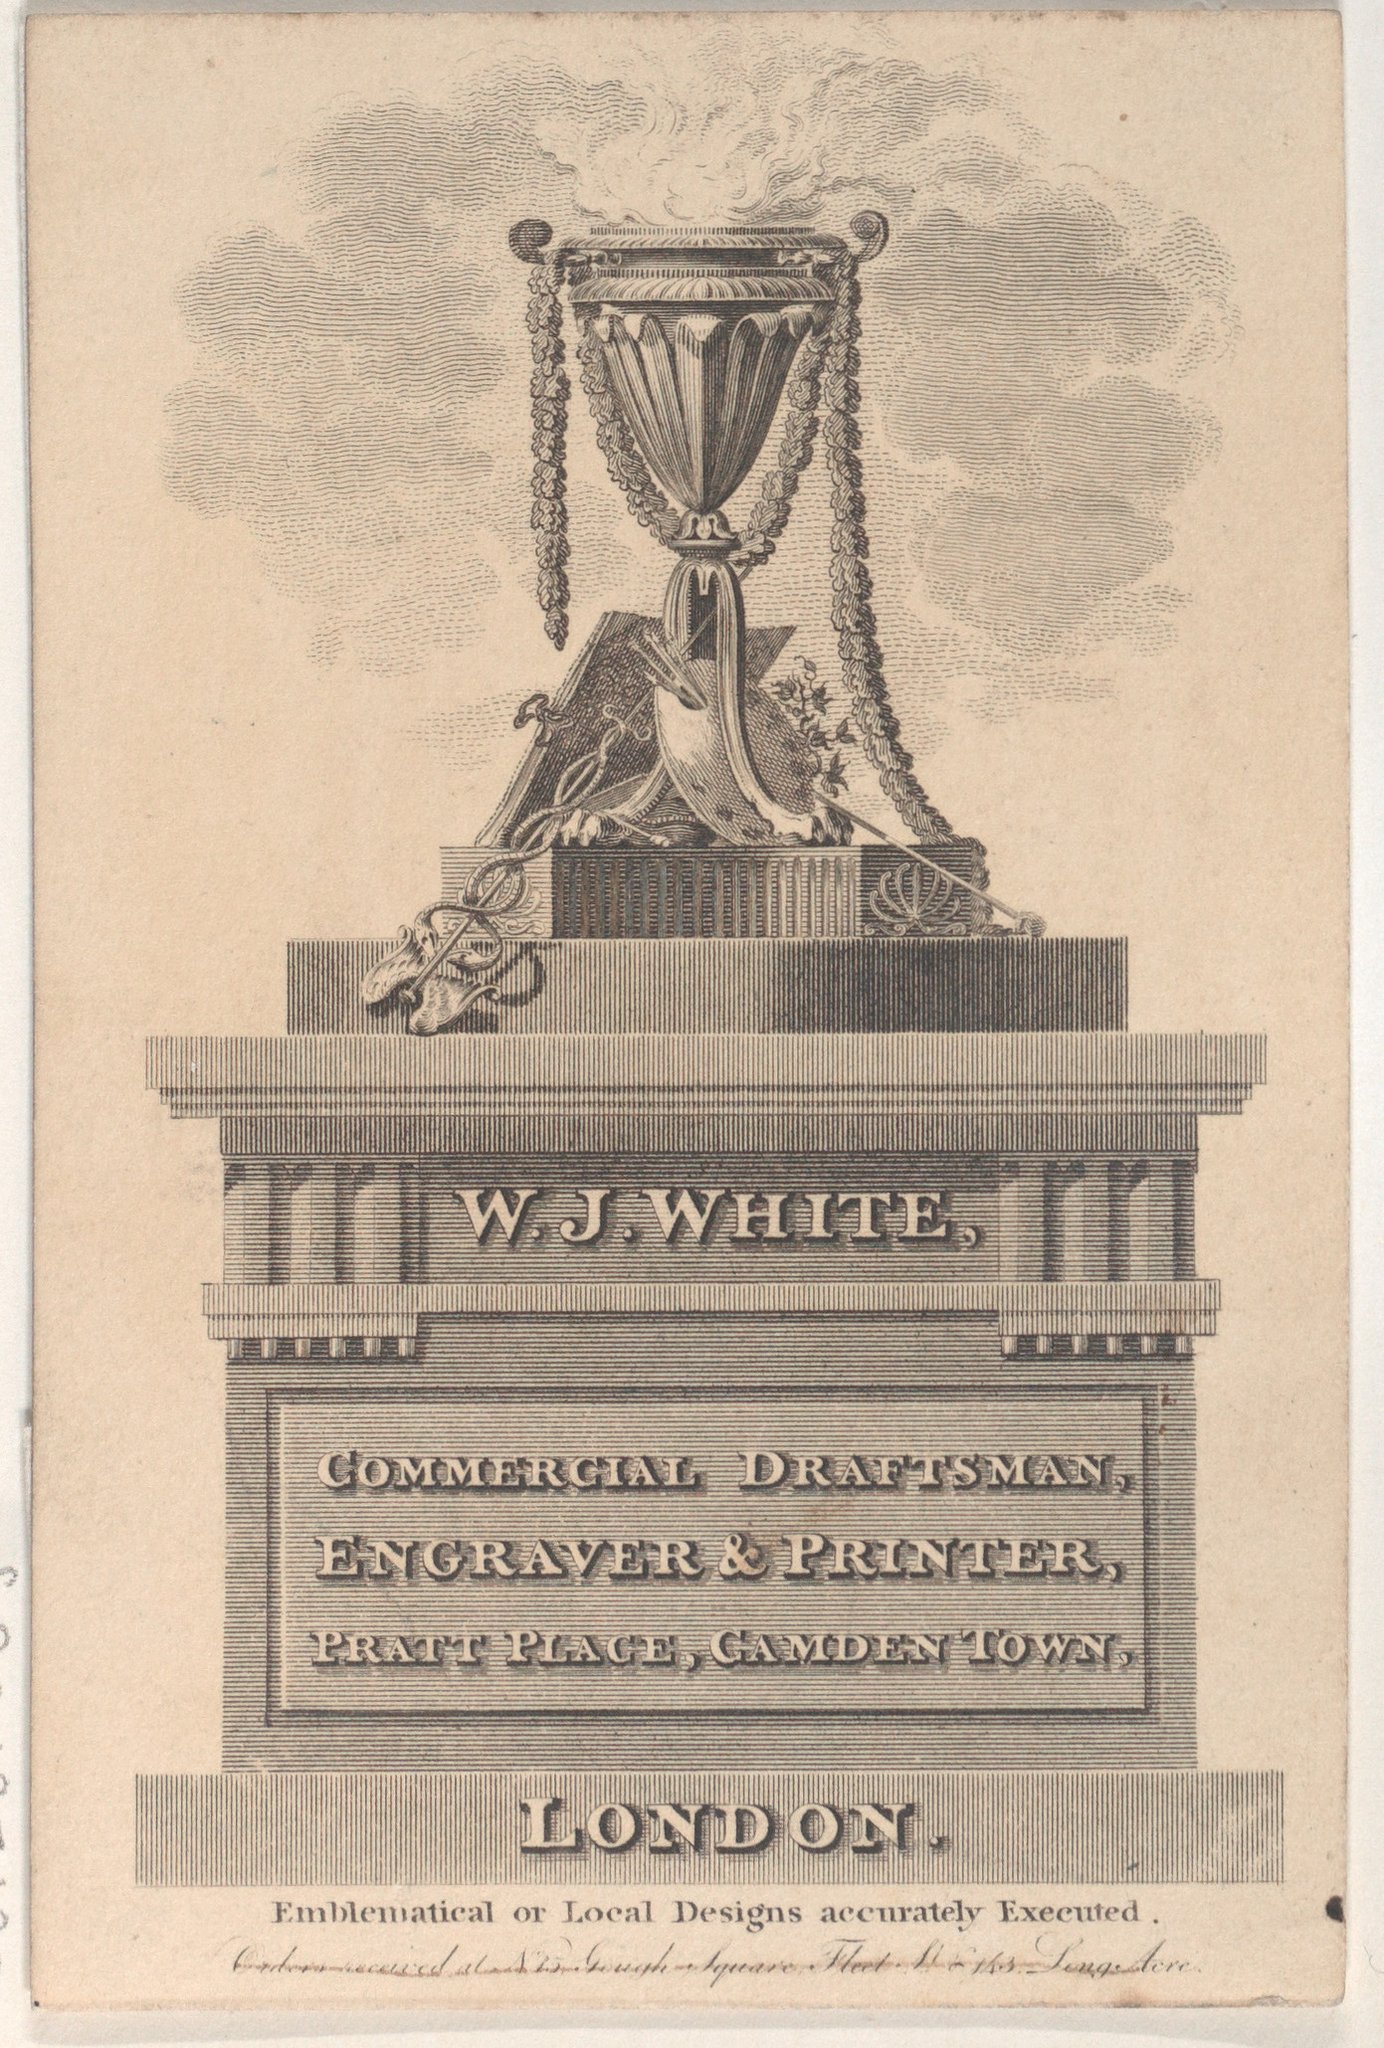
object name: print, trade card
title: Trade Card for W. J. White, Commercial Draftsman, Engraver & Printer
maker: anonymous, british, 19th century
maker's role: artist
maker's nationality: british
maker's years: 1800-1900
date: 1801-1900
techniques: engraving